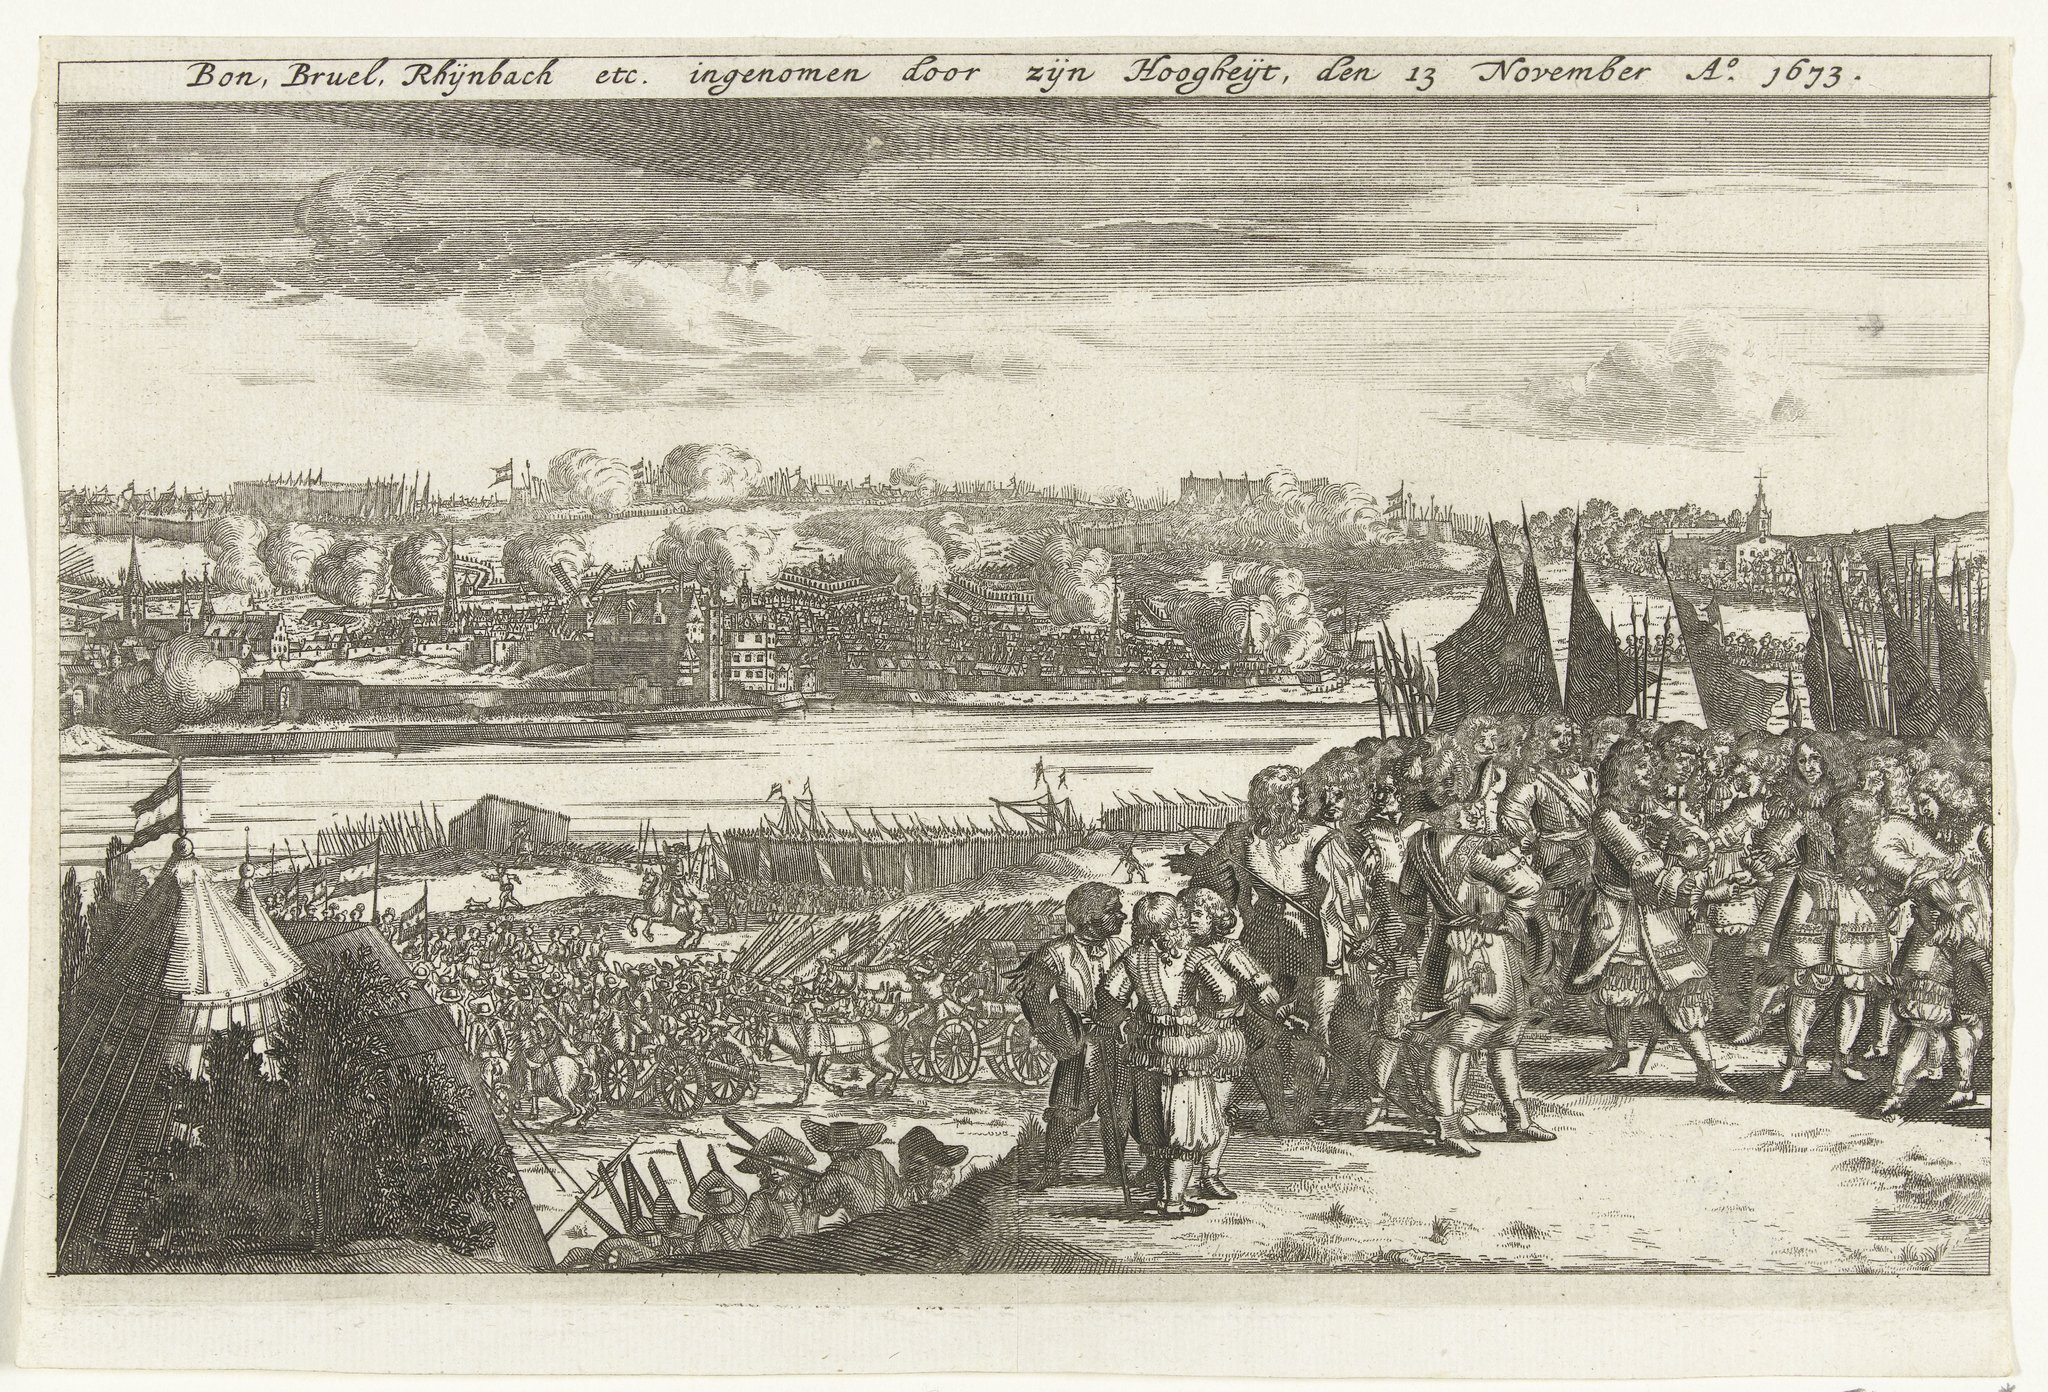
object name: print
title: Bon, Bruel, Rhijnbach etc. ingenomen door zijn Hoogheijt, den 13 November Ao. 1673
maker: Anonymous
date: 1674-1676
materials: paper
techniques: engraving, etching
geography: northern netherlands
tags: william iii (prince of orange and king of england, scotland, and ireland), capture of city (after the siege)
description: Verkleinde kopie naar de prent van Romeyn de Hooghe (FMH 2506) of naar de kopie (FMH 2507).. Gebruikt als illustratie in: T. van Domselaer, Het ontroerde Nederlandt, door de wapenen des konings van Vrankryk, 2 dln, M. Willemsz. Doornik, Amsterdam 1674-1676, dl. II, p. 720.